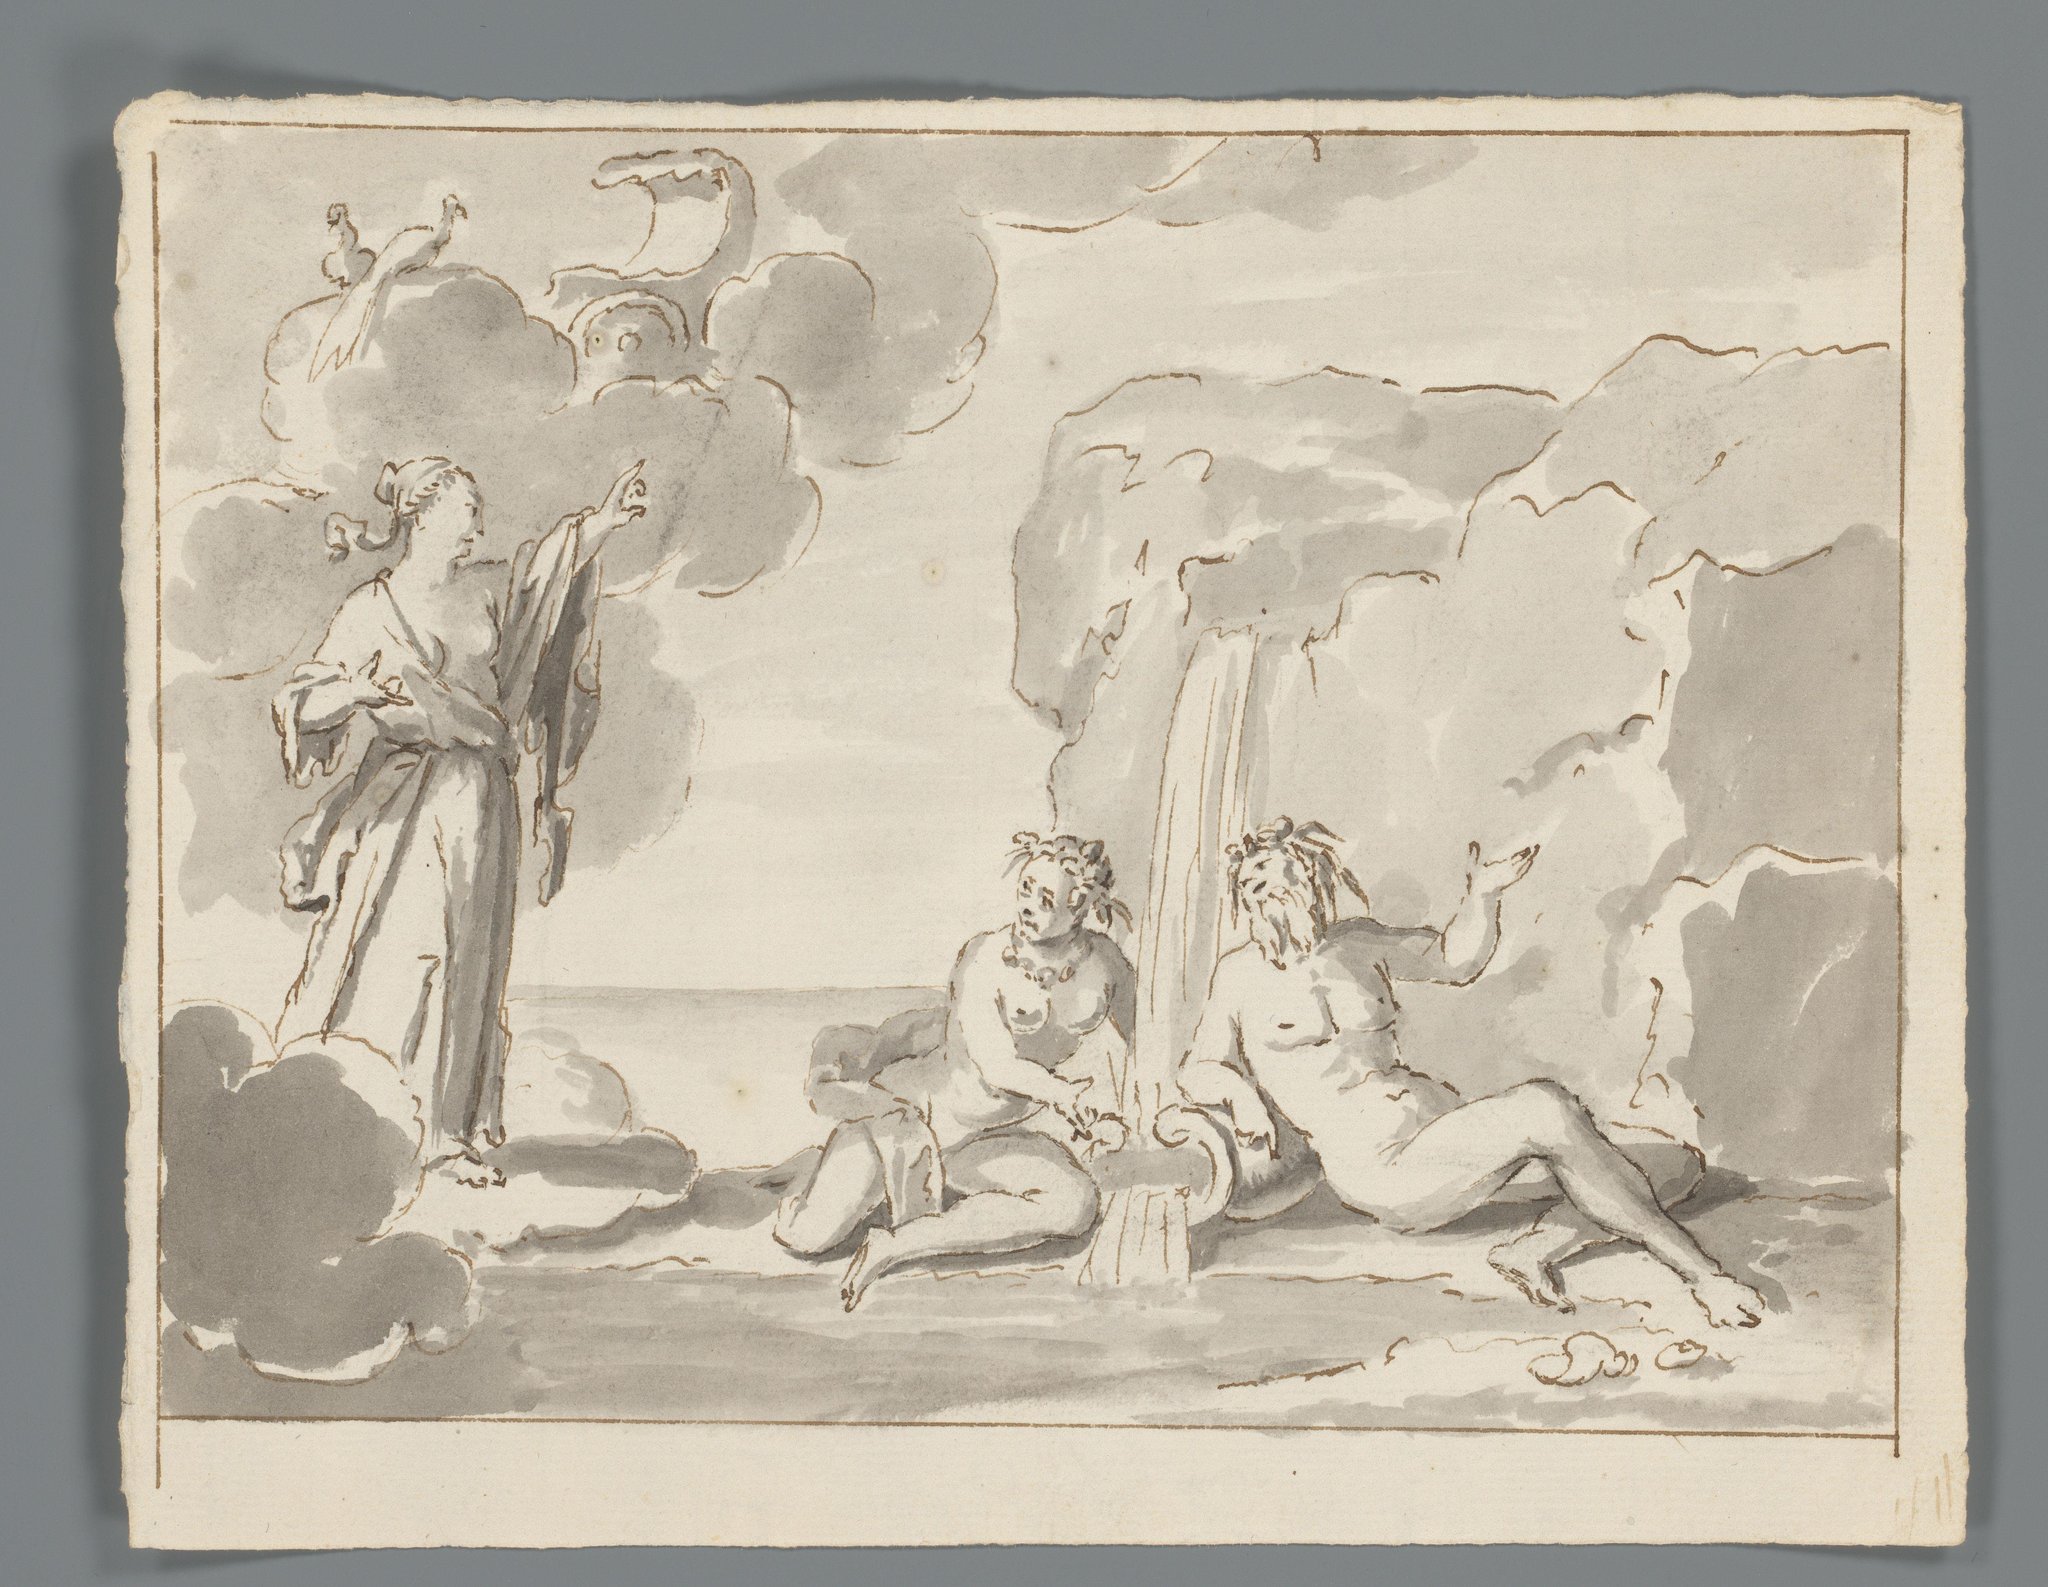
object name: drawing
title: Juno beklaagt zich bij Thetis en Oceanus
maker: matthijs balen (1684-1766)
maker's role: draughtsman, painter, print maker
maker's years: 1684-1766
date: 1694-1766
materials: paper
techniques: brush, pen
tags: (story of) juno (hera), (story of) oceanus, (story of) thetis; 'thethi, ninfa del mare' (ripa)